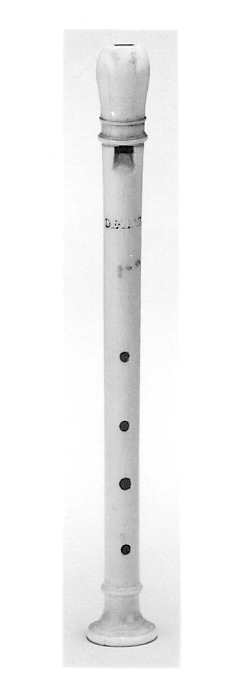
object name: flageolet in g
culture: belgian or dutch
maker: de haze?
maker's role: maker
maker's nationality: dutch or belgian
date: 1601-1700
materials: ivory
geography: netherlands or belgium